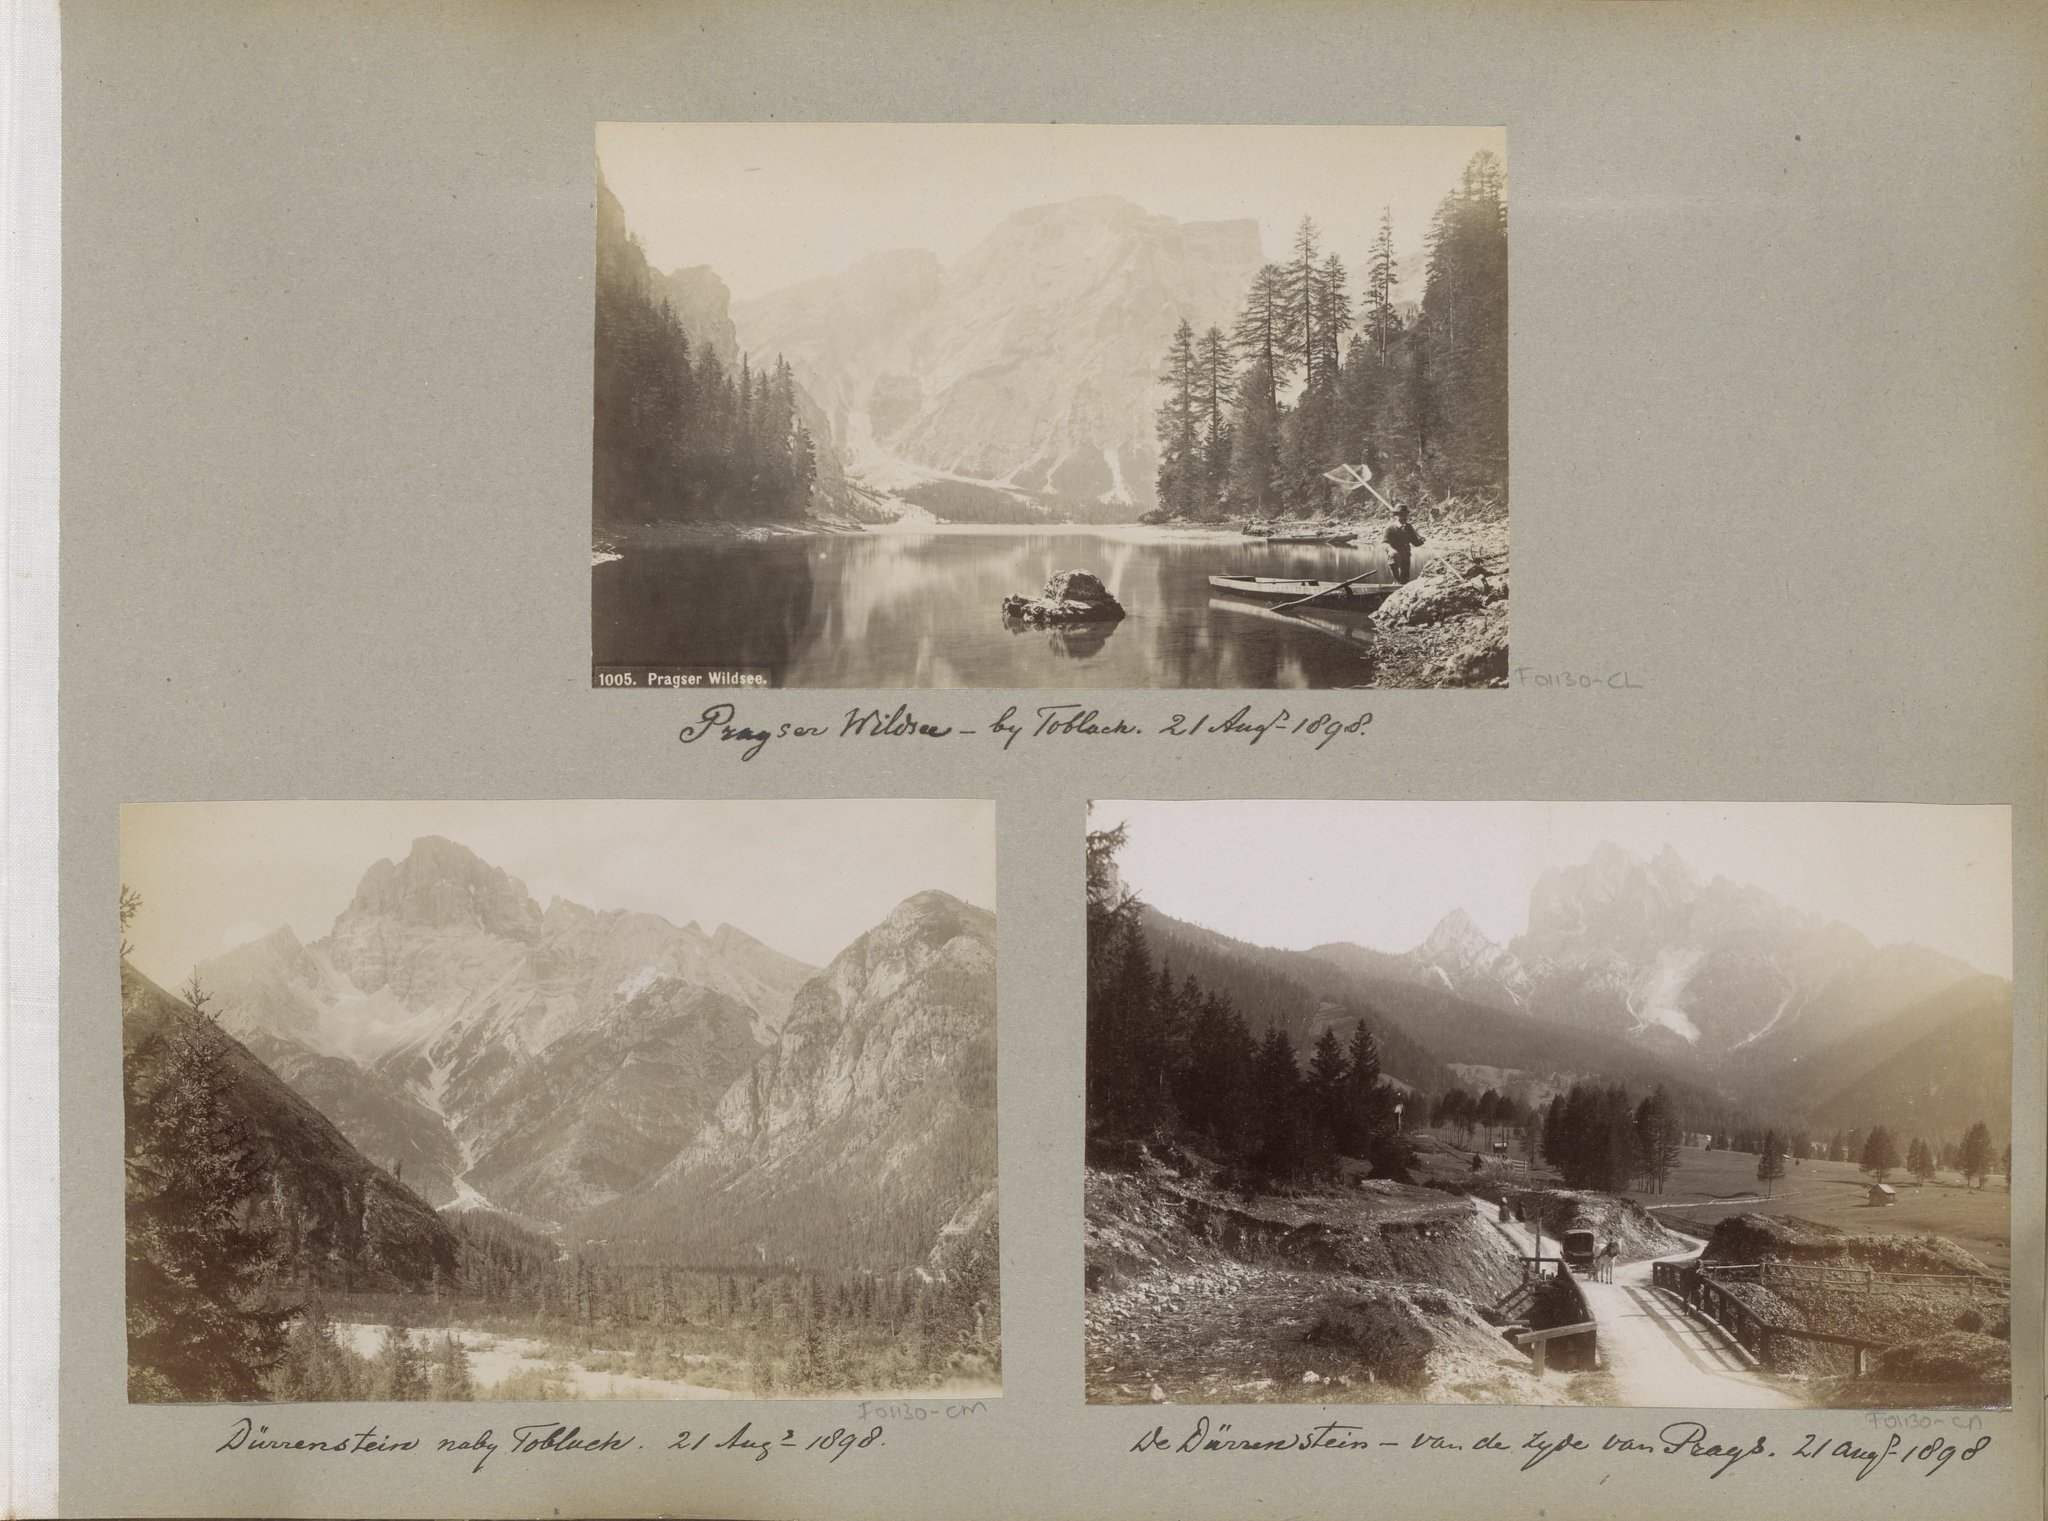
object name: photograph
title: Gezicht op de berg Dürrenstein bij Toblach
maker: Anonymous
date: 1880-1898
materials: paper, photographic support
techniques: albumen print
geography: toblach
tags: mountains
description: Onderdeel van Reisalbum met foto's van bezienswaardigheden in Frankrijk, Spanje, Italië, Duitsland, Zwitserland en Oostenrijk.